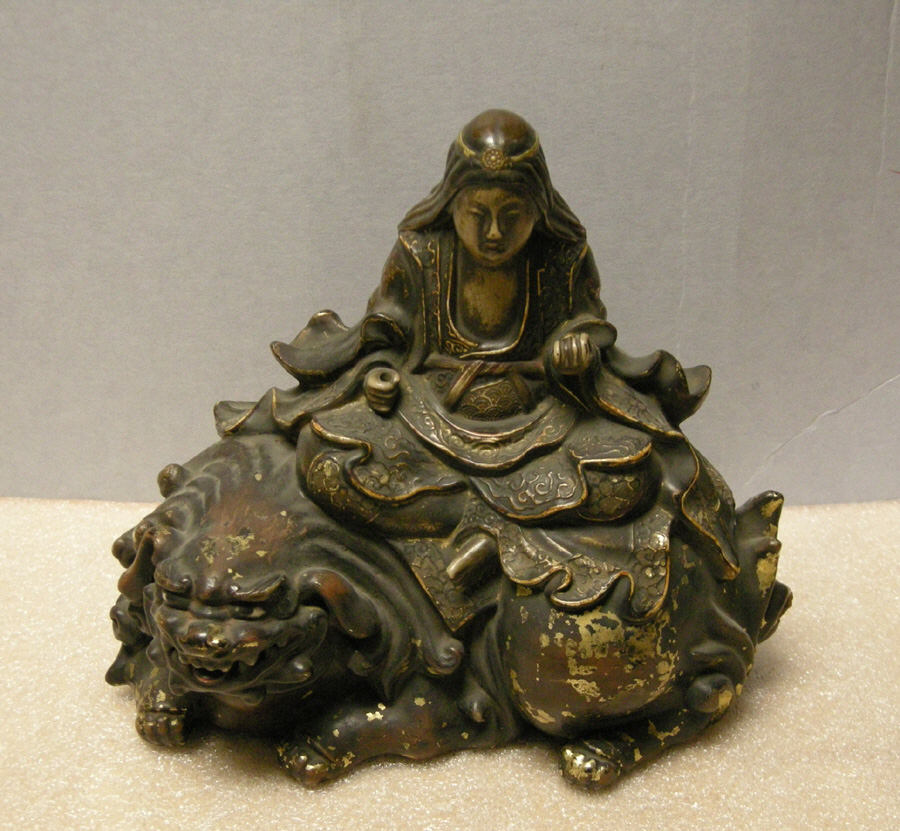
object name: figure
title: Monjū, the Bodhisattva of Wisdom, on a Lion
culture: japanese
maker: ogawa haritsu (ritsuō)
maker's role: artist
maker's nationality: japanese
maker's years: 1663-1747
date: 1701-1750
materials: gold foil, lacquer, pigment, porcelain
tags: lions,buddhism,bodhisattvas